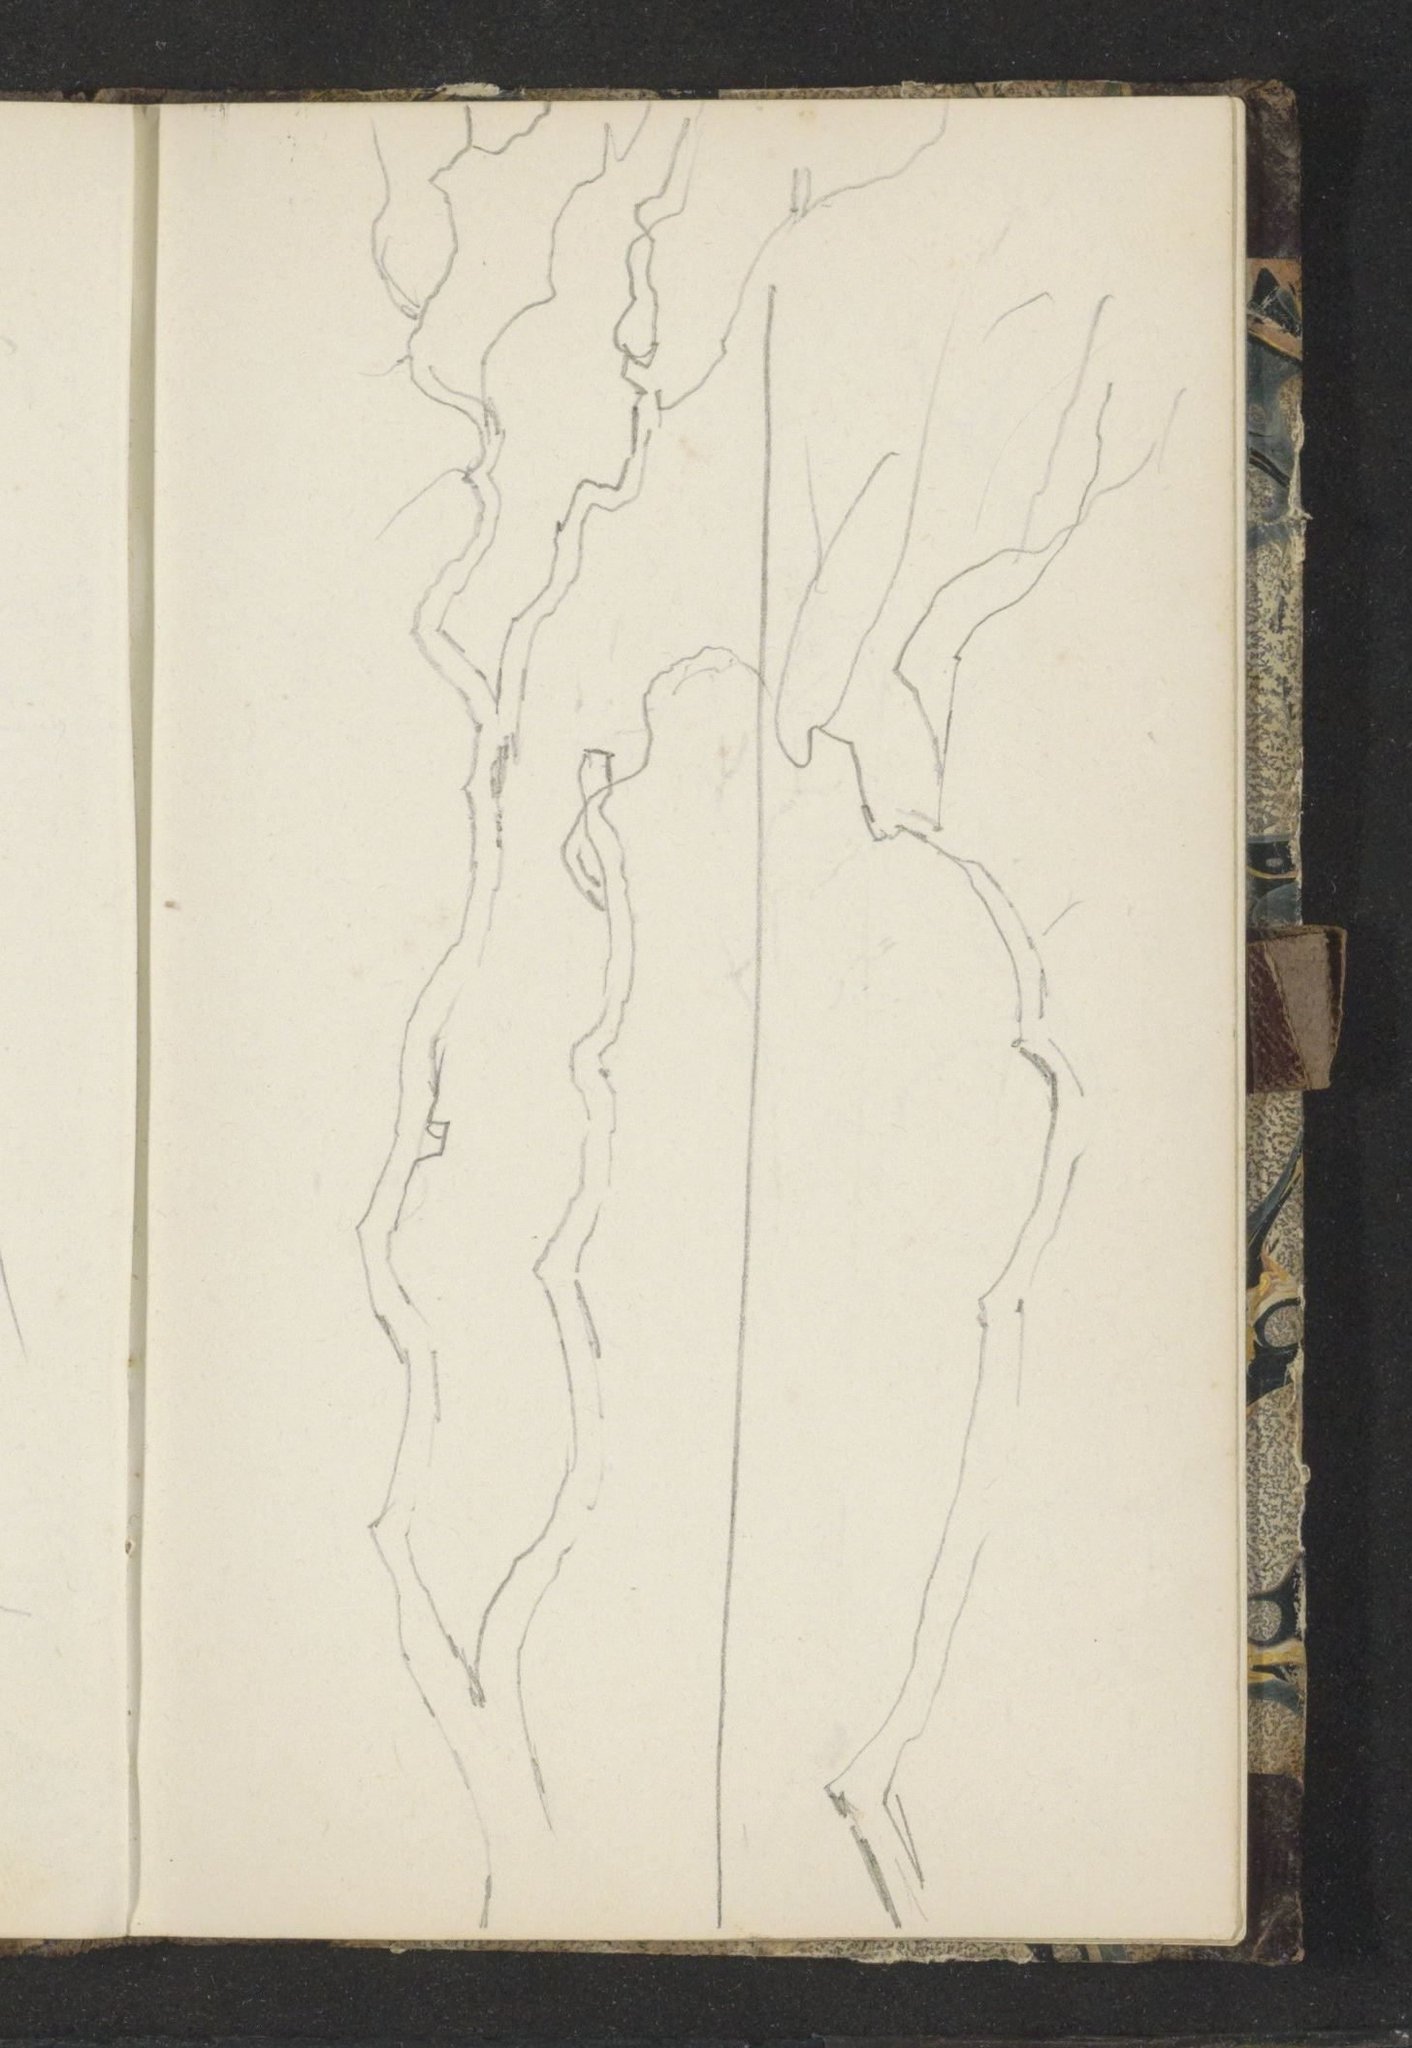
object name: sketchbook leaf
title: Boomtakken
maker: Anonymous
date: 1802-1874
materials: paper, pencil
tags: trees (+ branch, stick)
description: Blad 11 recto uit een schetsboek met 19 bladen.